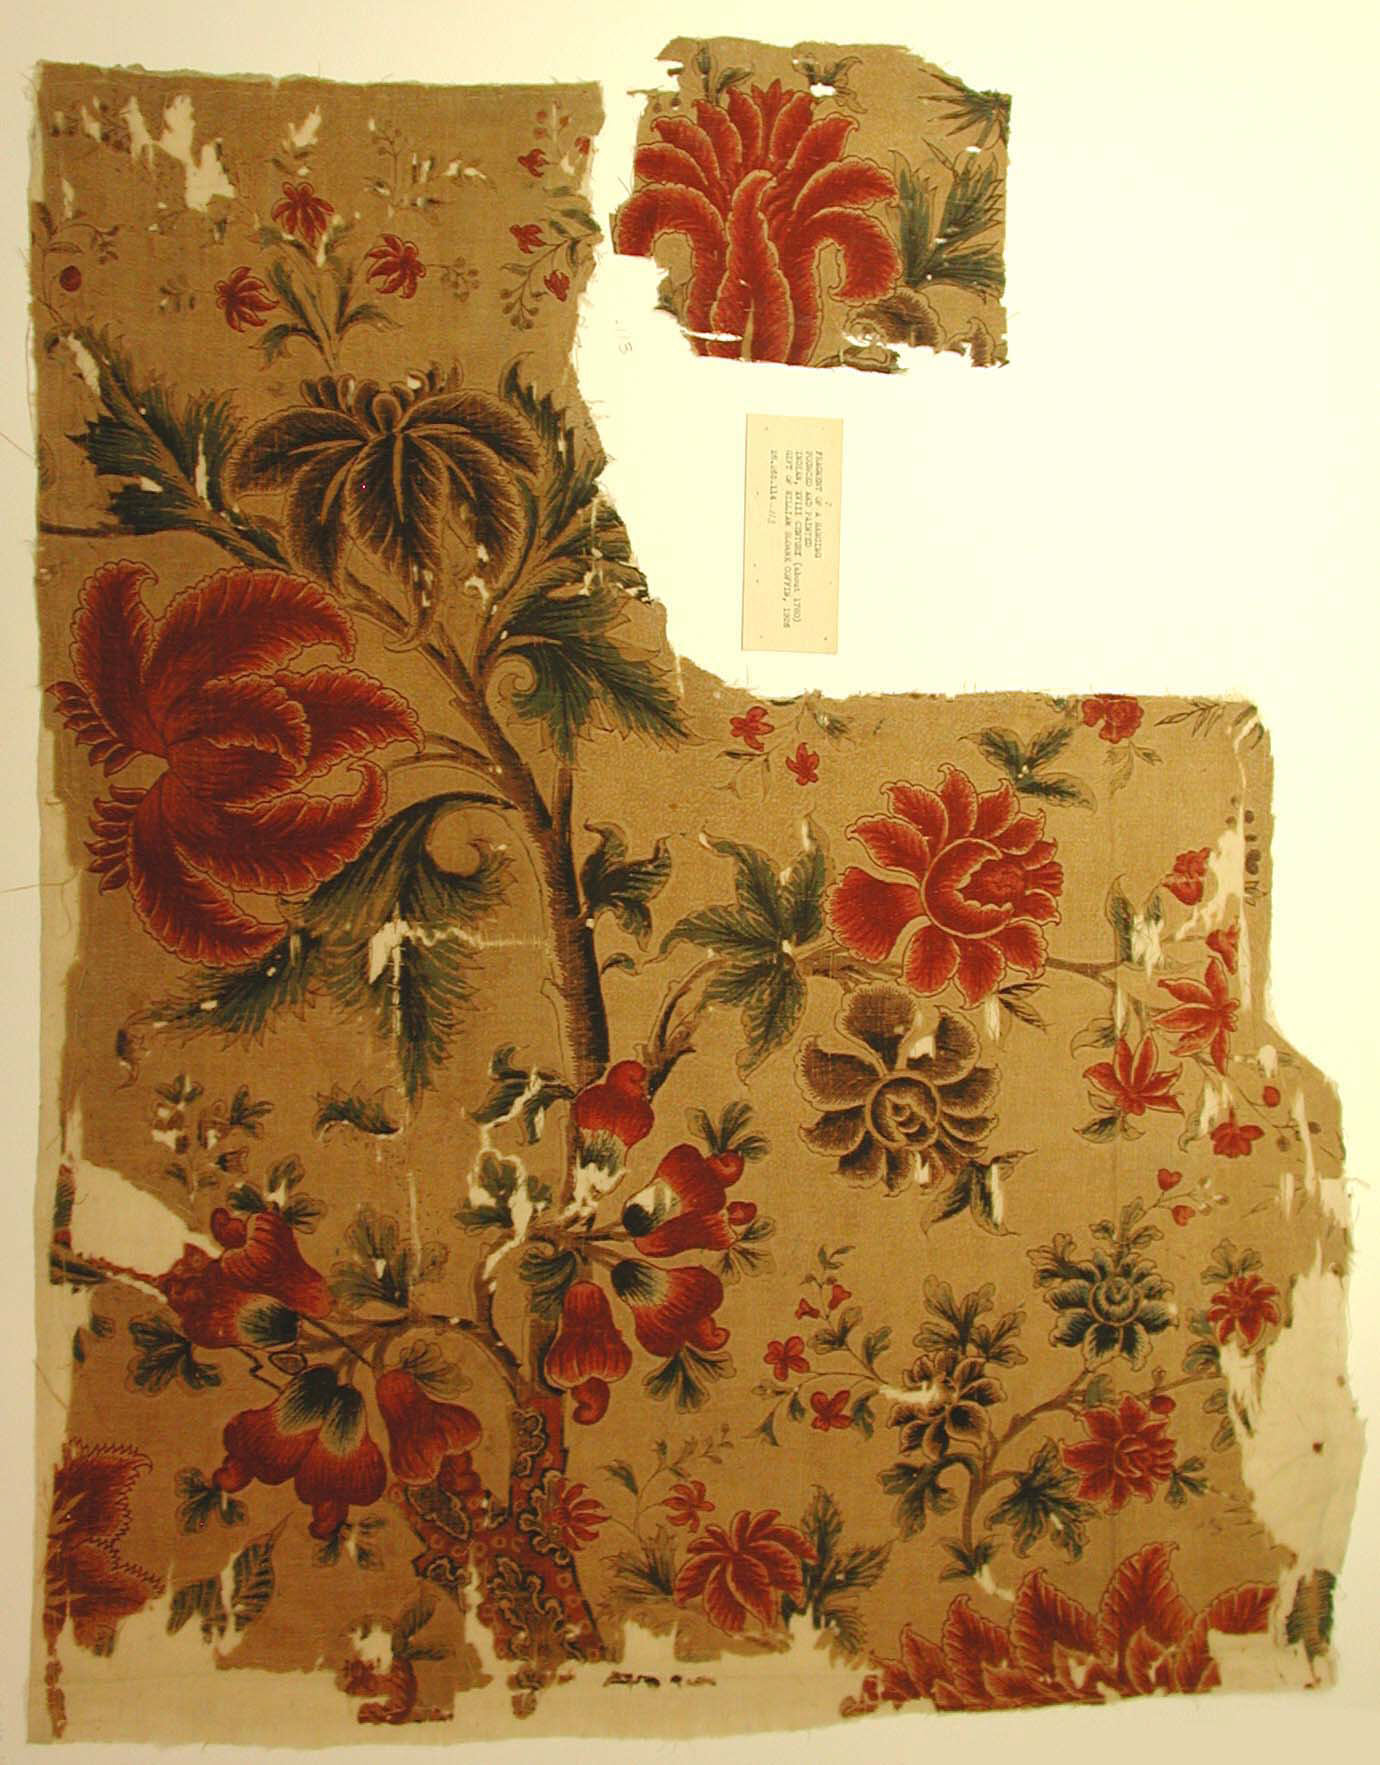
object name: fragment of a veil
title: Fragment of a Veil (Yashmak)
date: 1701-1800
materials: cotton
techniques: painting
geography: india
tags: flowers